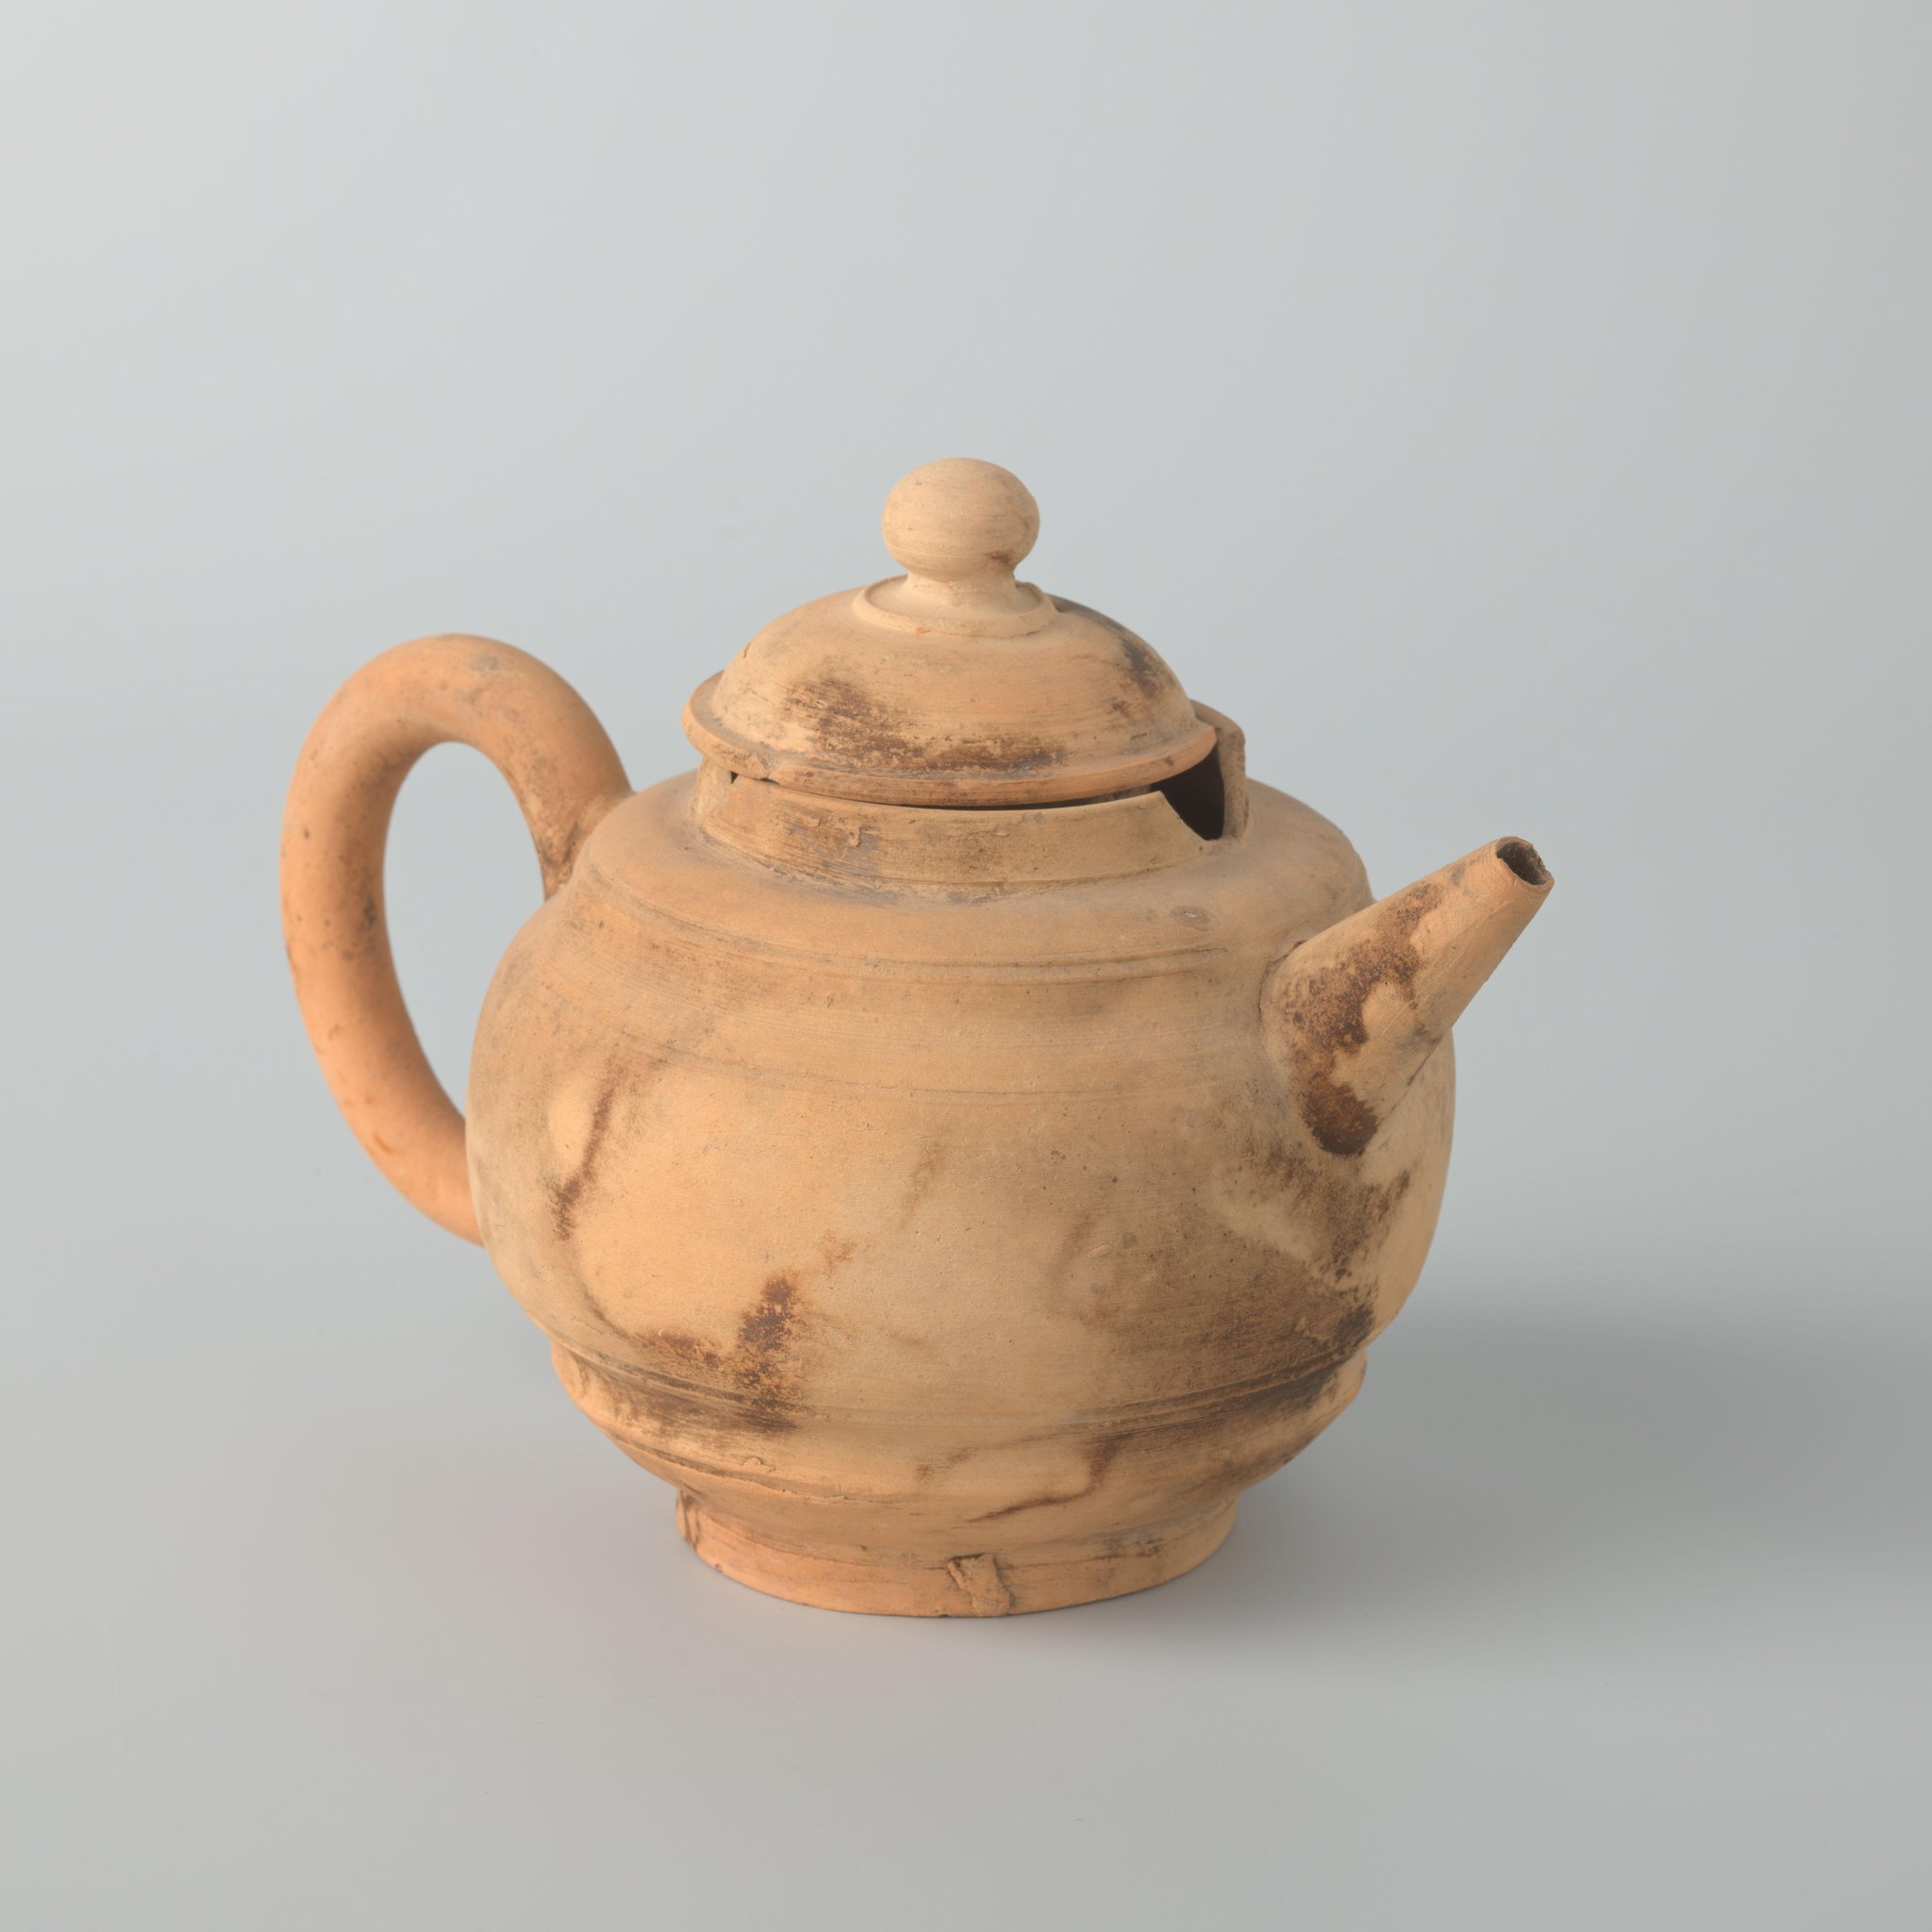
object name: teapot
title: Theepot van ongeglazuurd aardewerk (De Caluwe bakafval)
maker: jacobus de caluwe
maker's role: plateelbakkerij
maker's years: -1730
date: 1700-1725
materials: earthenware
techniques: firing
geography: delft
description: Toegeschreven aan Jacobus de Caluwe, omdat dit voorwerp samen met gemerkte stukken (‘Jacobus De Caluwe’ en rennend hert) gevonden is op de plaats waar zich De Caluwes tweede werkplaats bevond. Er is een duidelijke stilistische overeenkomst tussen de gemerkte en niet gemerkte voorwerpen uit deze archeologische vondst.